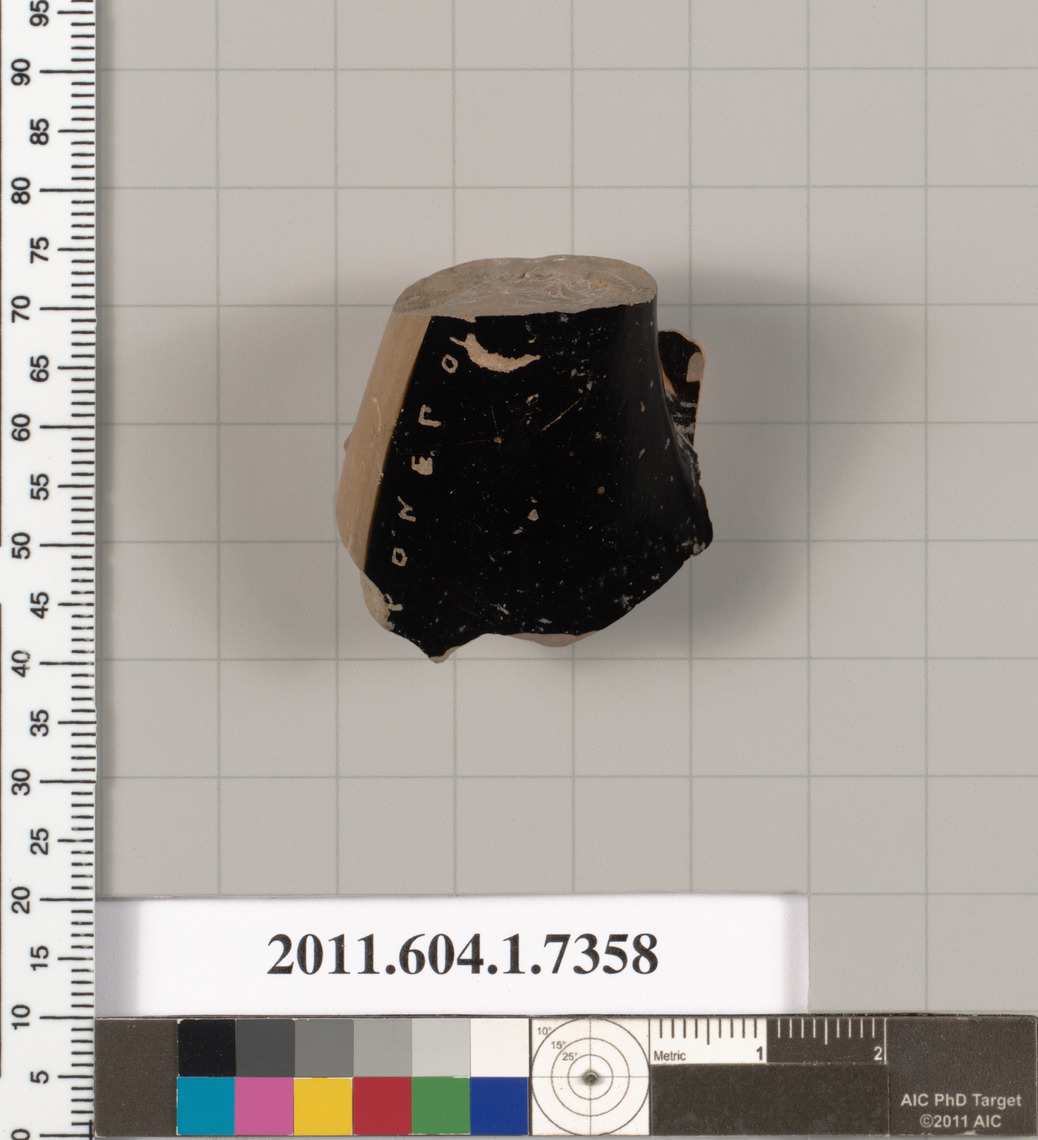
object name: kylix fragment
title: Terracotta fragment of a kylix (drinking cup)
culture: greek, attic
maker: makron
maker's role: artist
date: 500-480 BCE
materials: terracotta